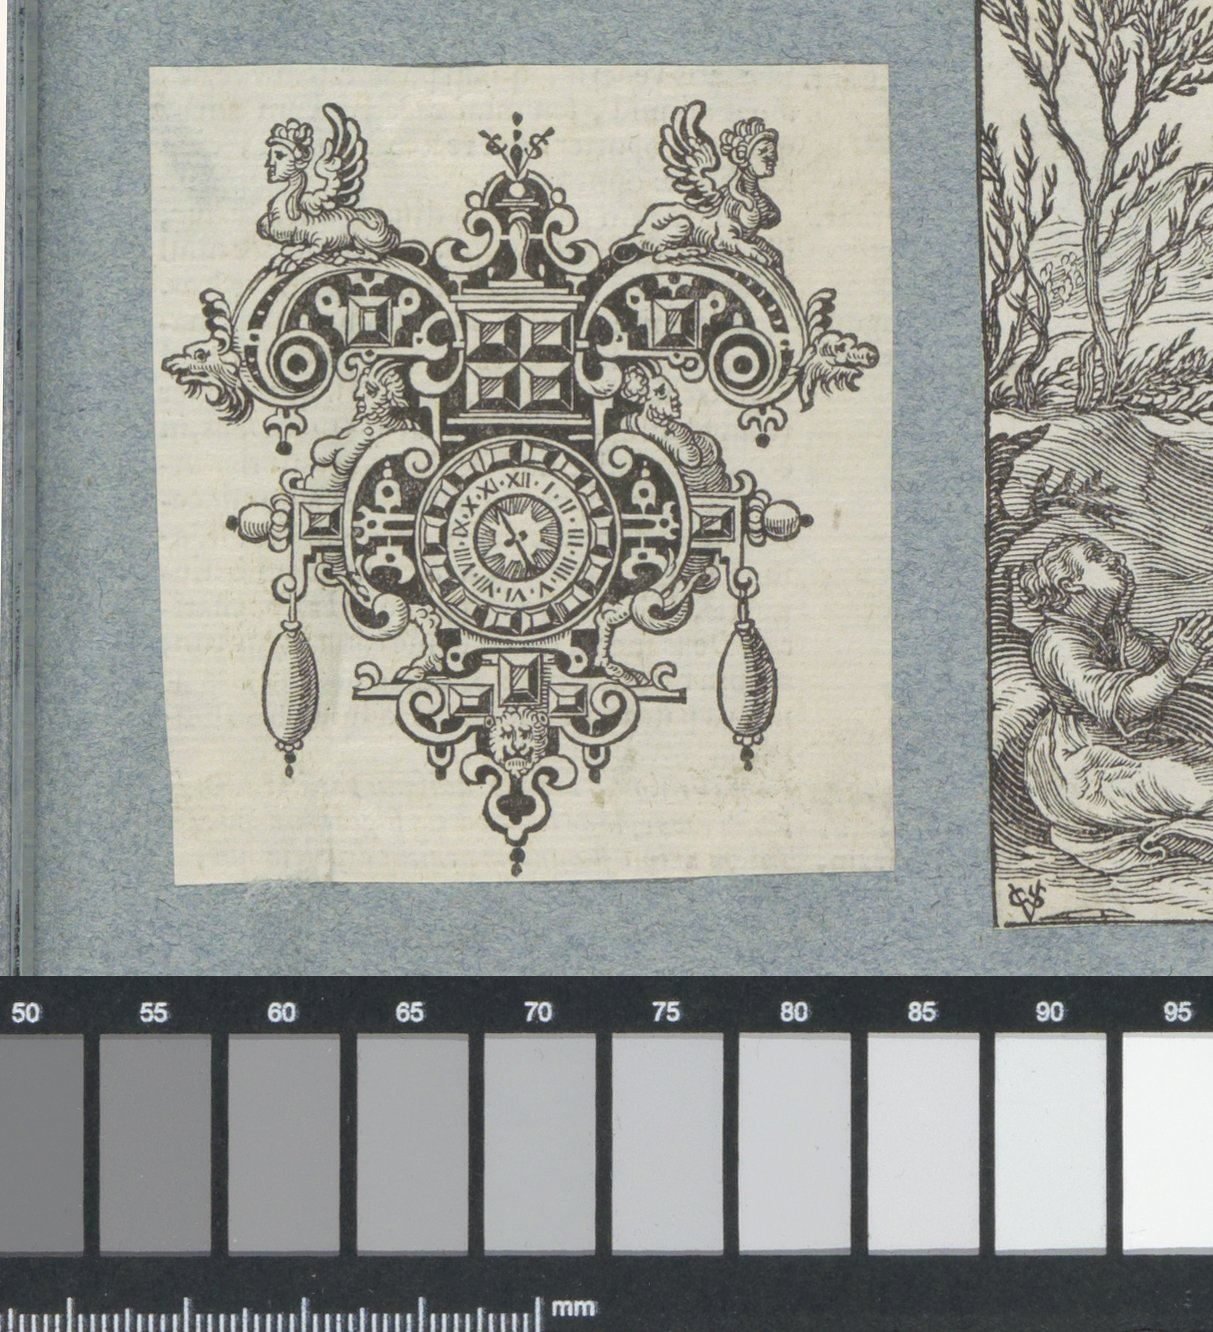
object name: ornament print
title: Ornament met sfinxen en klok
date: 1628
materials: paper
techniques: letterpress printing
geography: amsterdam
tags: ornamental decoration ~ printed matter, book, clock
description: Ornament uit: Herman Hugo, Pia desideria emblematis, elegiis & affectibus S. S. Patrum illustrata, Antwerpen 1628. Volgens de titelpagina verscheen dit werk in Antwerpen bij Hendrick Aertssens, in werkelijkheid verscheen het in Amsterdam bij Pieter Jacobsz Paets (Dietz 2012, p. 58-59).